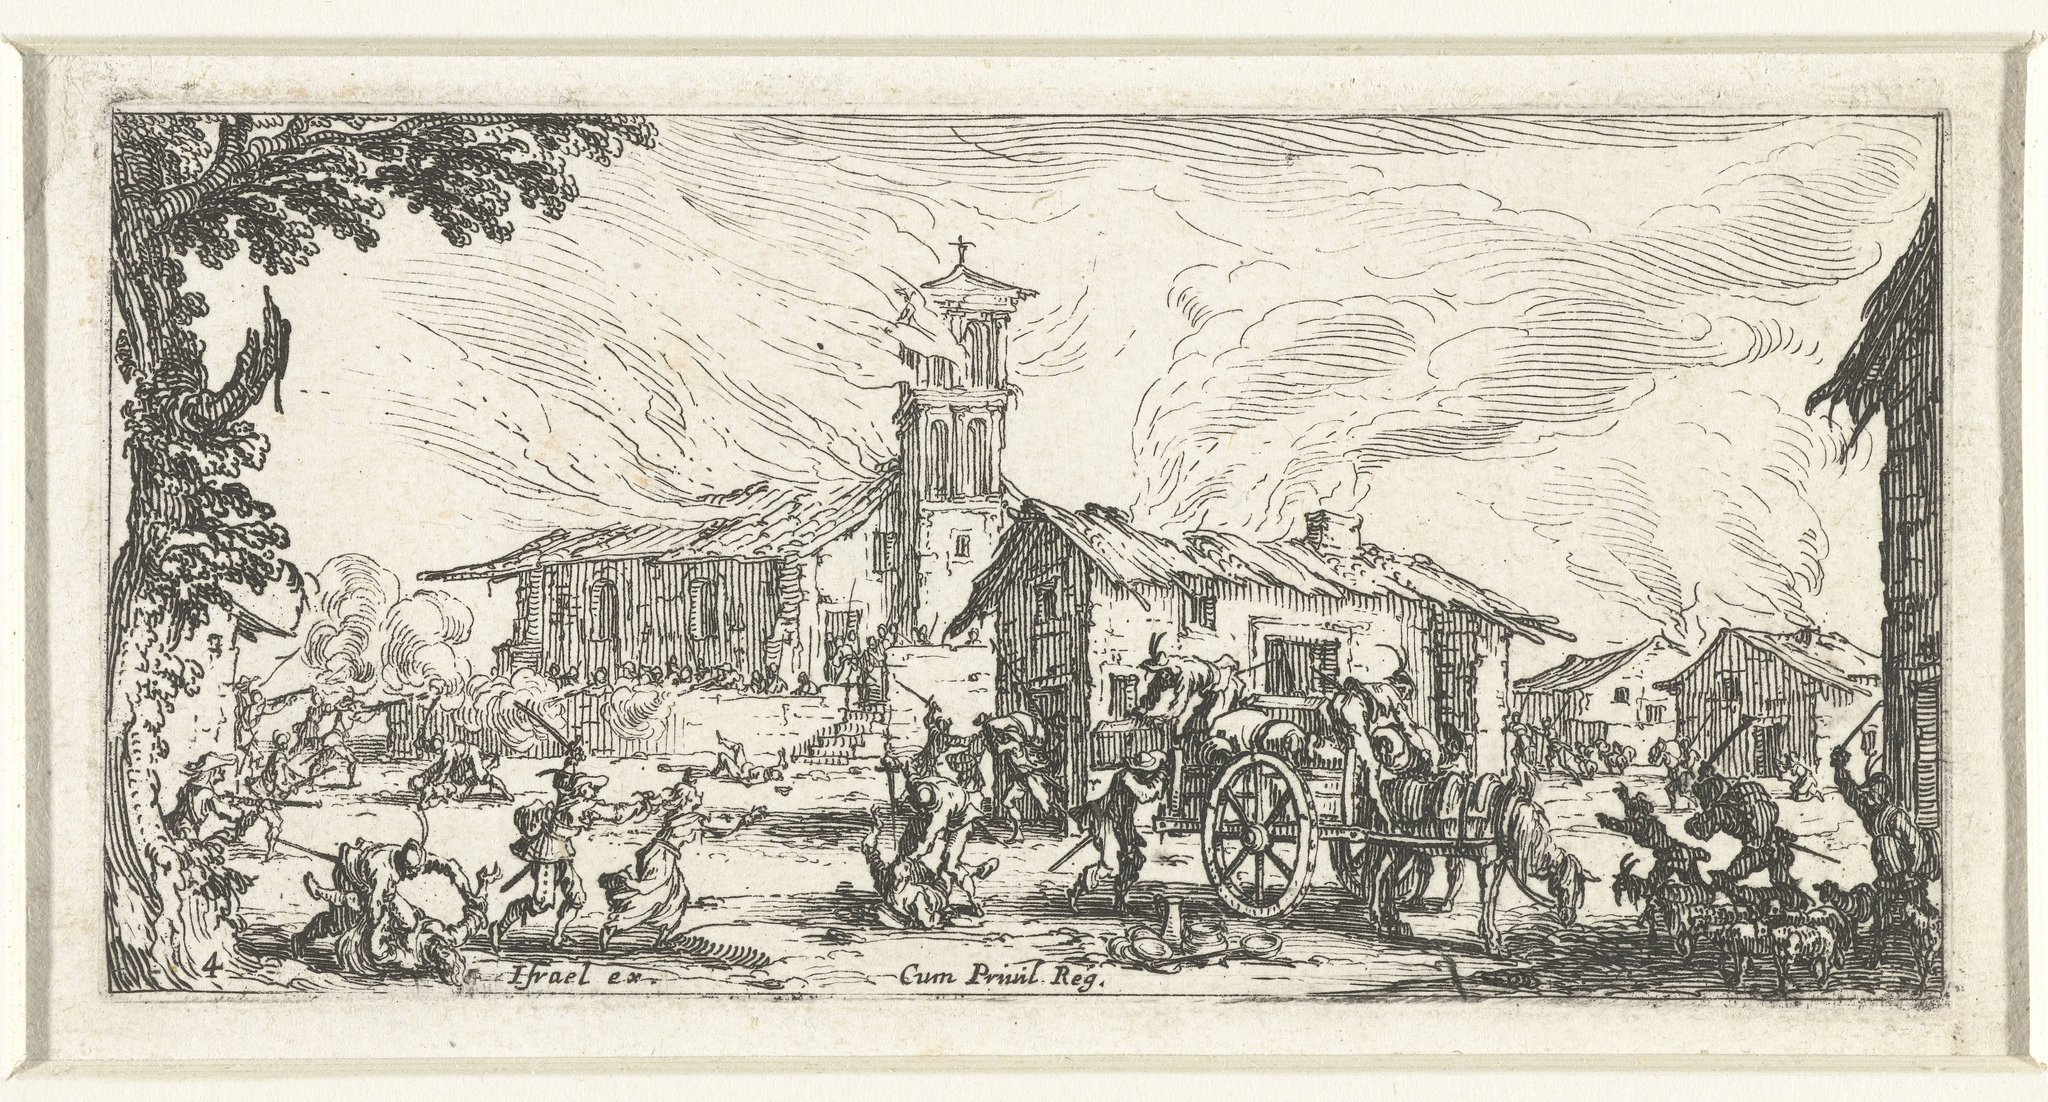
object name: print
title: De gruwelen van de oorlog (klein)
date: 1632-1636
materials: paper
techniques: etching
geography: paris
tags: village, plundering ~ soldiers, soldiers and civilians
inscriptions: collector's mark: Lugt 240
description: In een dorp roven soldaten spullen uit huizen en laden ze op een kar. Dorpelingen worden gemolesteerd. De dorpskerk en enkele huizen staan in brand. Deze prent is onderdeel van een serie van zes (zeven incl. titelprent) kleine prenten met voorstellingen van diverse soorten ellende die oorlogvoering met zich meebrengt.